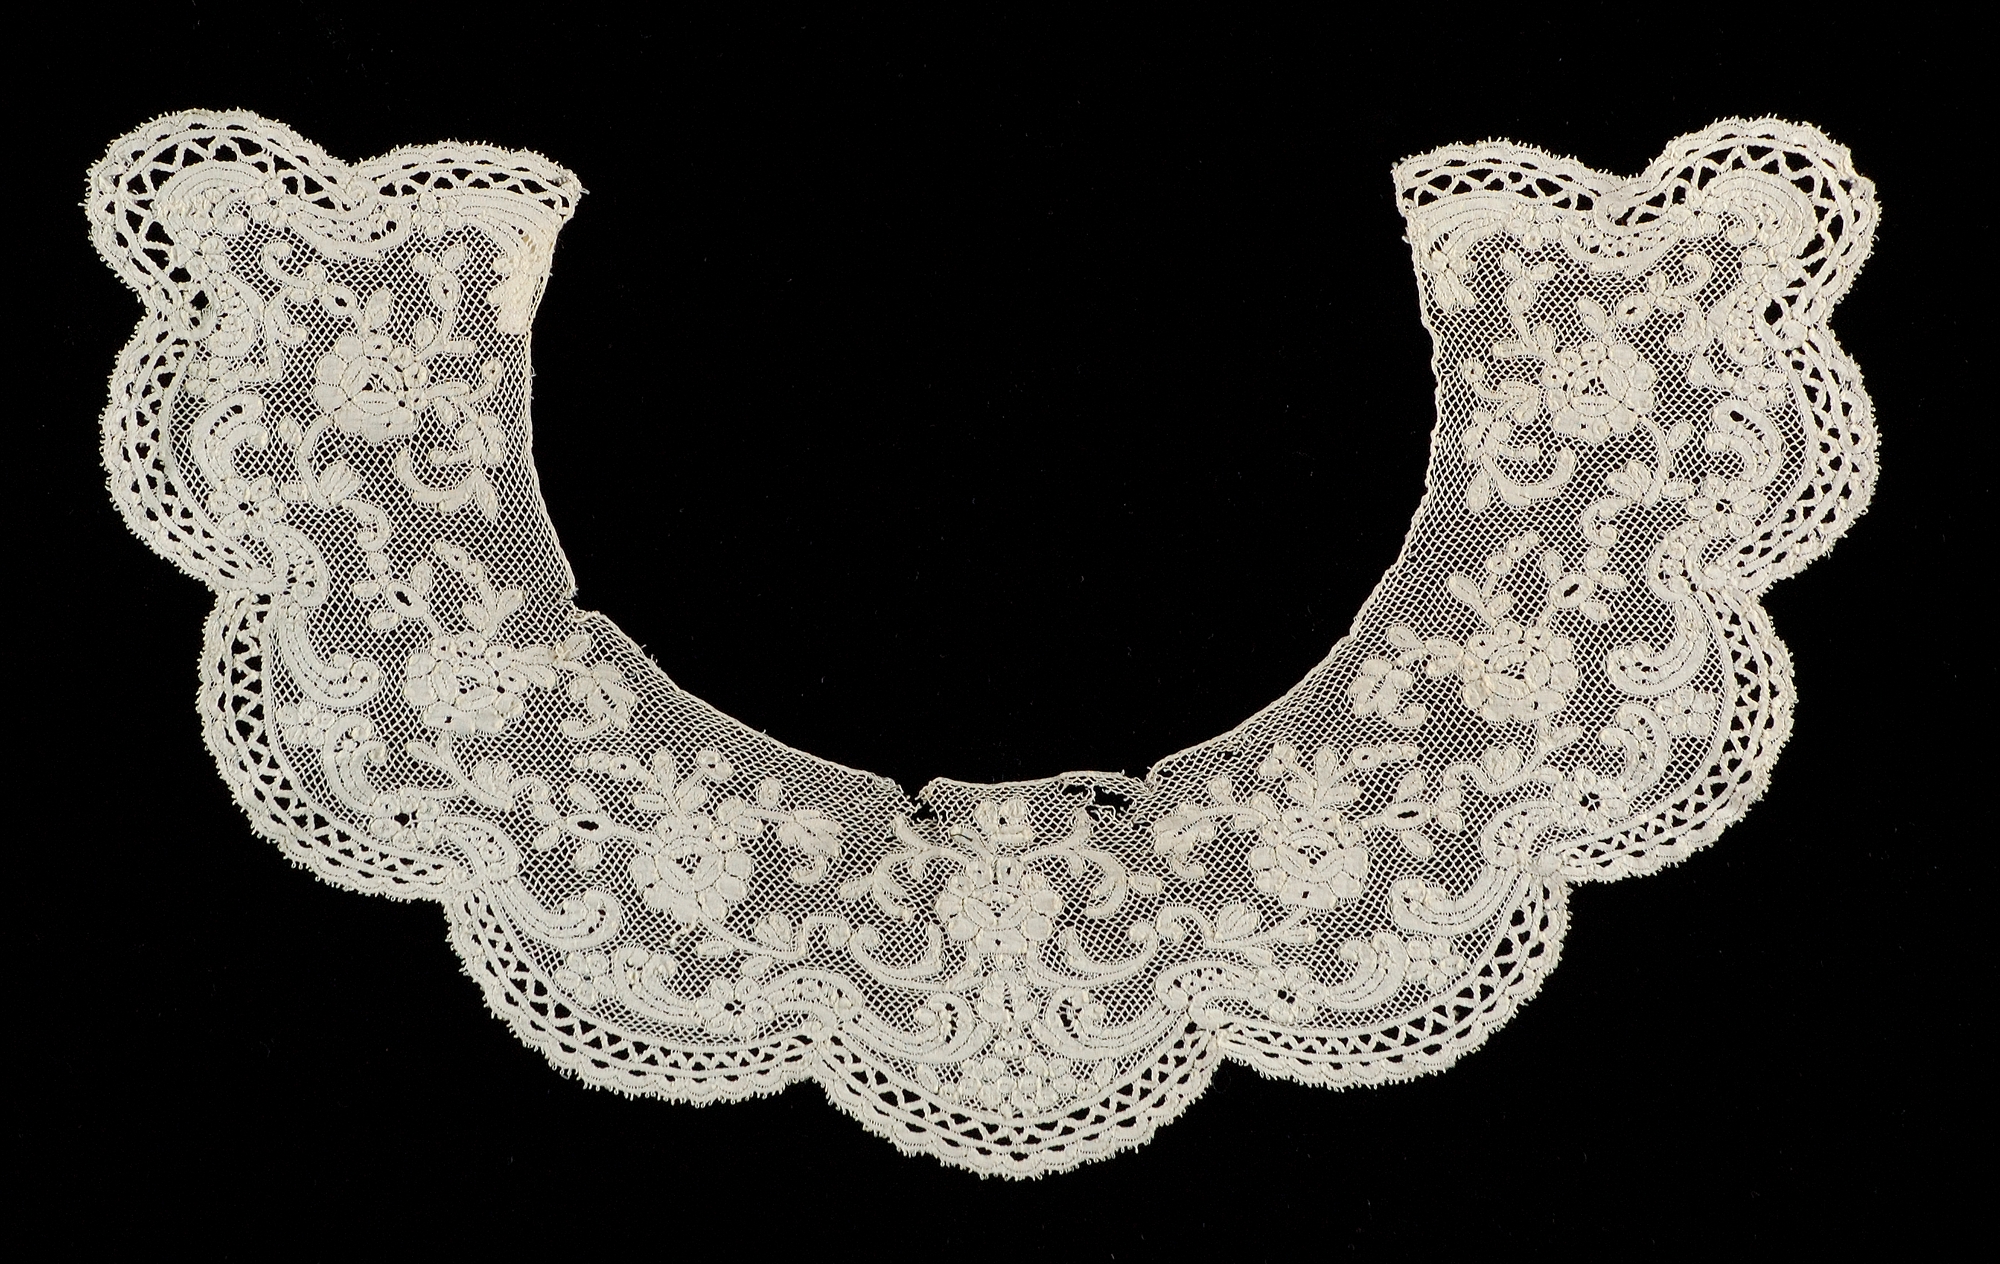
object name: collar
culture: european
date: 1860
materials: linen